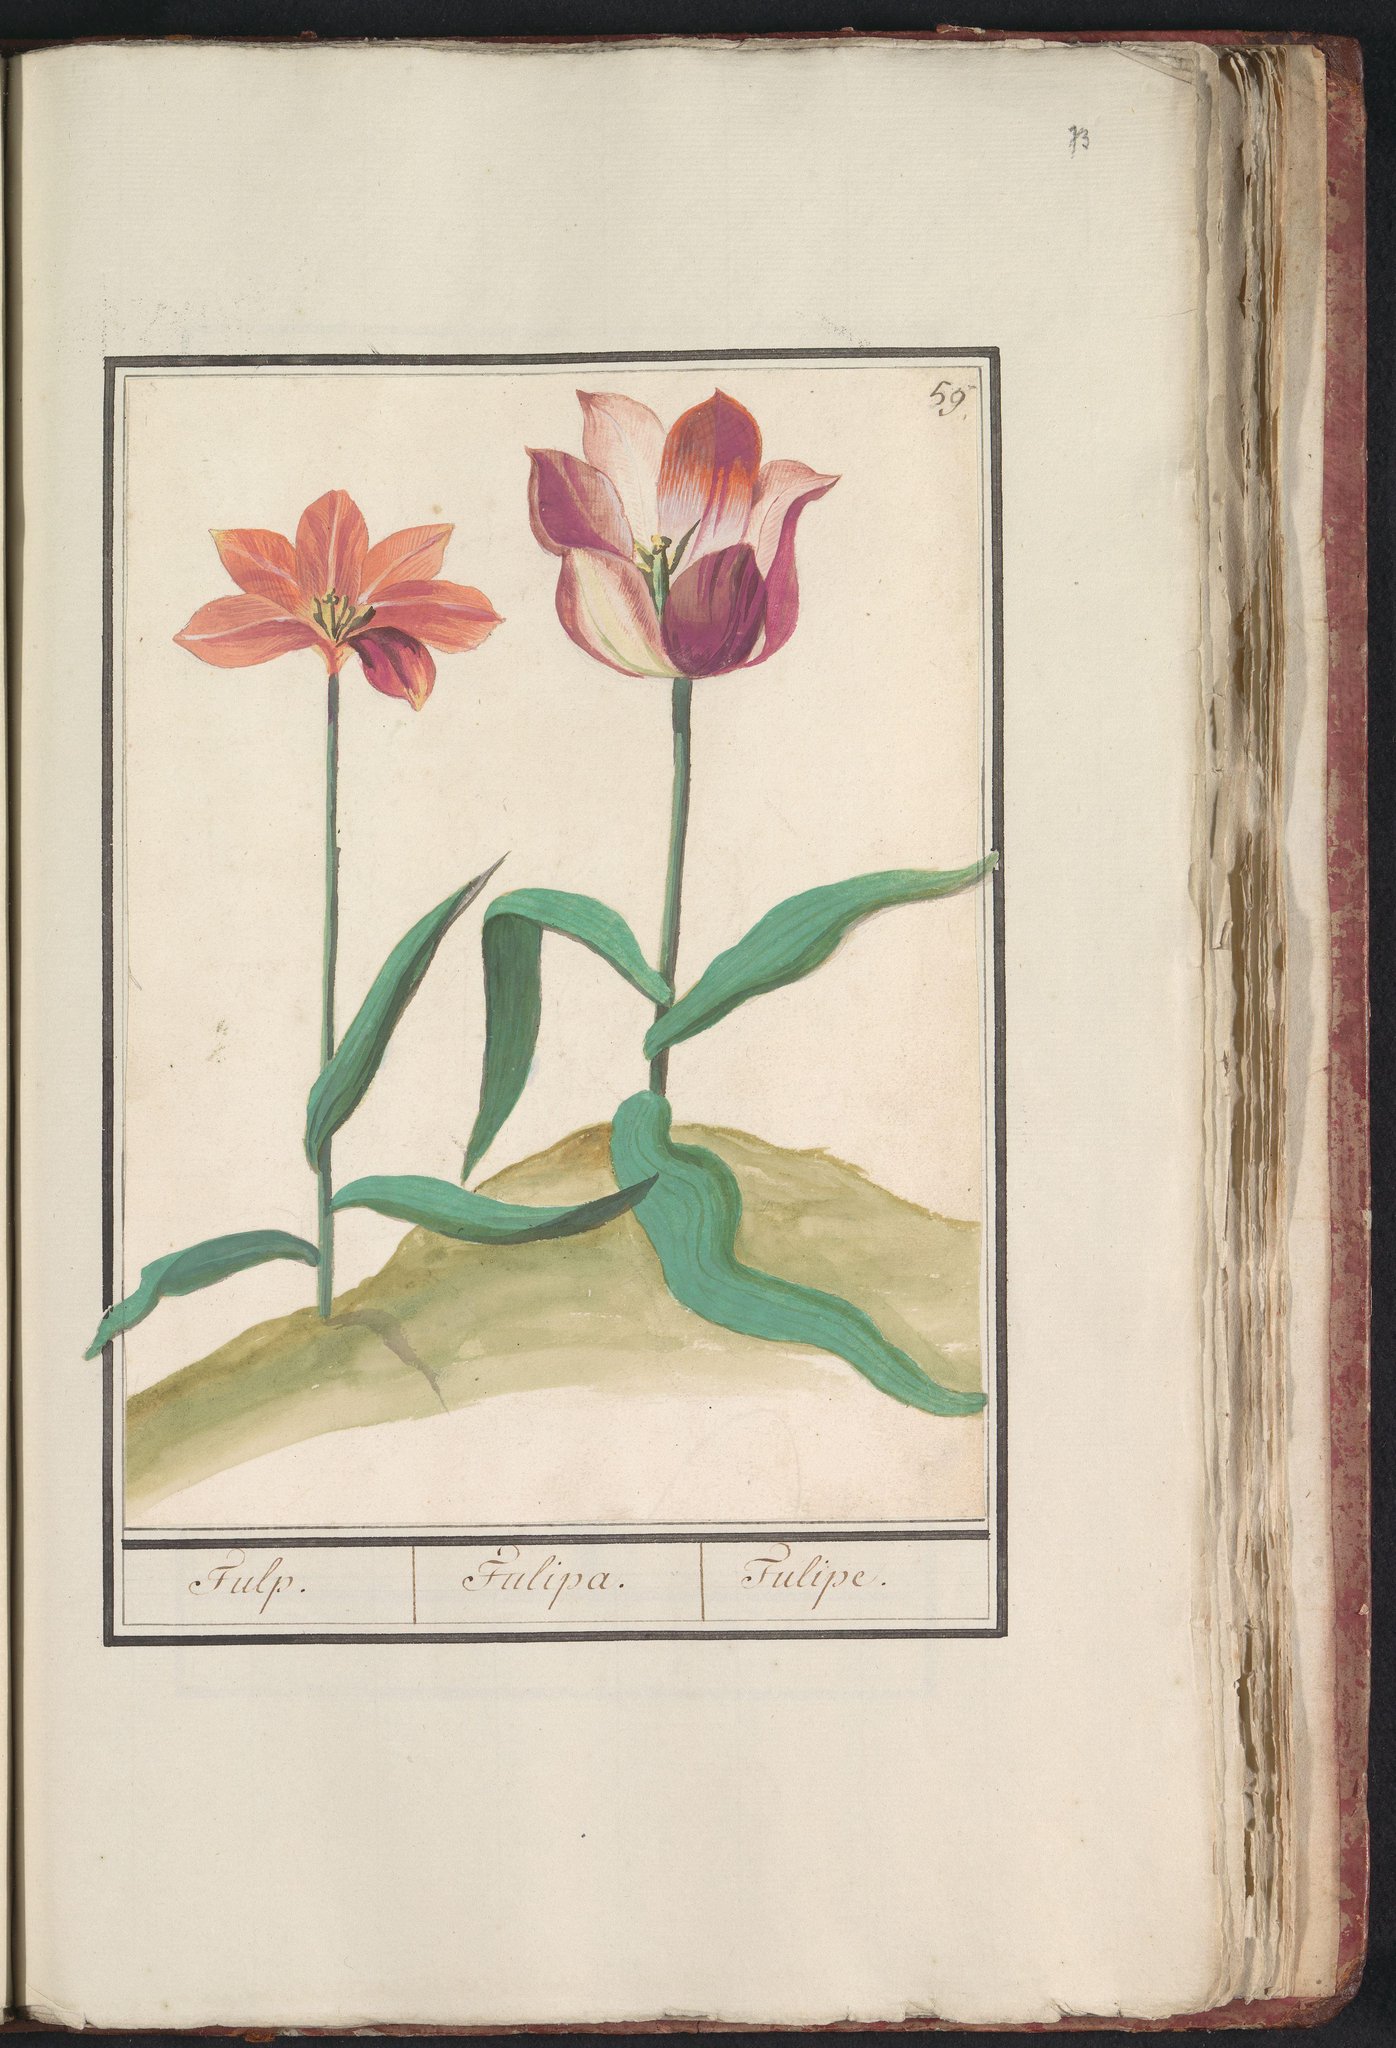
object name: drawing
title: Tulp (Tulipa)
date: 1596-1610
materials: chalk, paint, paper, watercolor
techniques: brush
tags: flowers: tulip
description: Twee roze tulpen, in de grond. Genummerd rechtsboven: 59. Onderdeel van het eerste album met tekeningen van bloemen en planten. Achtste van twaalf albums met tekeningen van dieren, vogels en planten bekend rond 1600, gemaakt in opdracht van keizer Rudolf II. Met toelichting in Nederlands, Latijn en Frans.